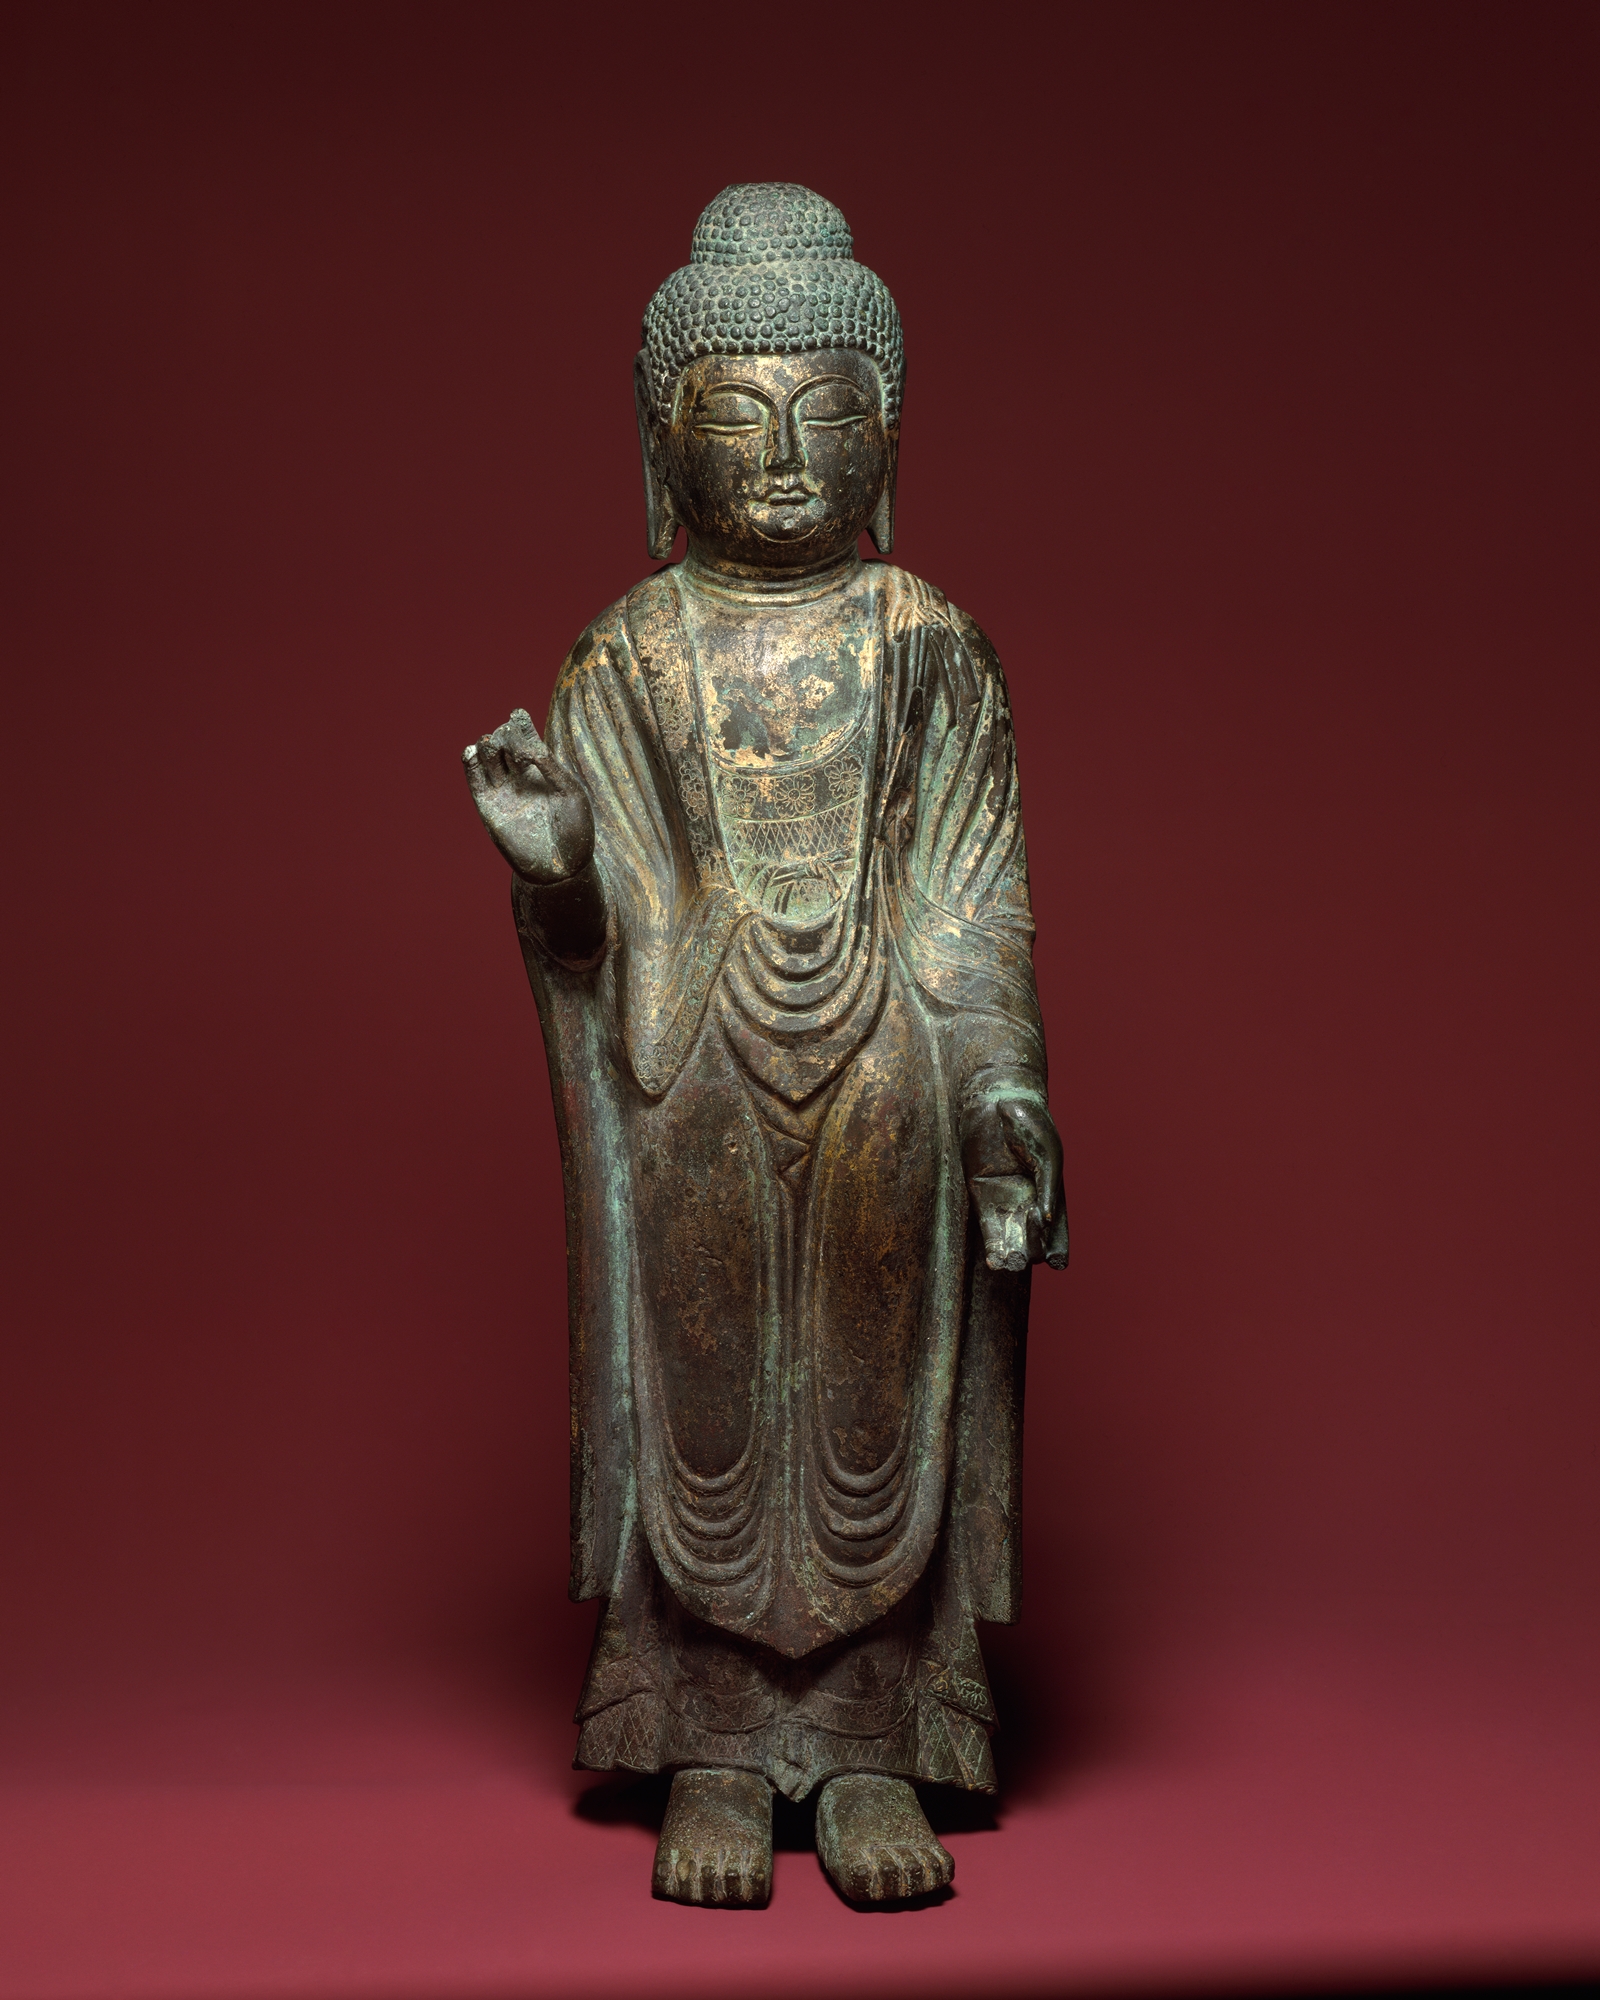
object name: figure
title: Standing Buddha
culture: korean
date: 918-1392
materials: gilt bronze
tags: buddhism,buddha